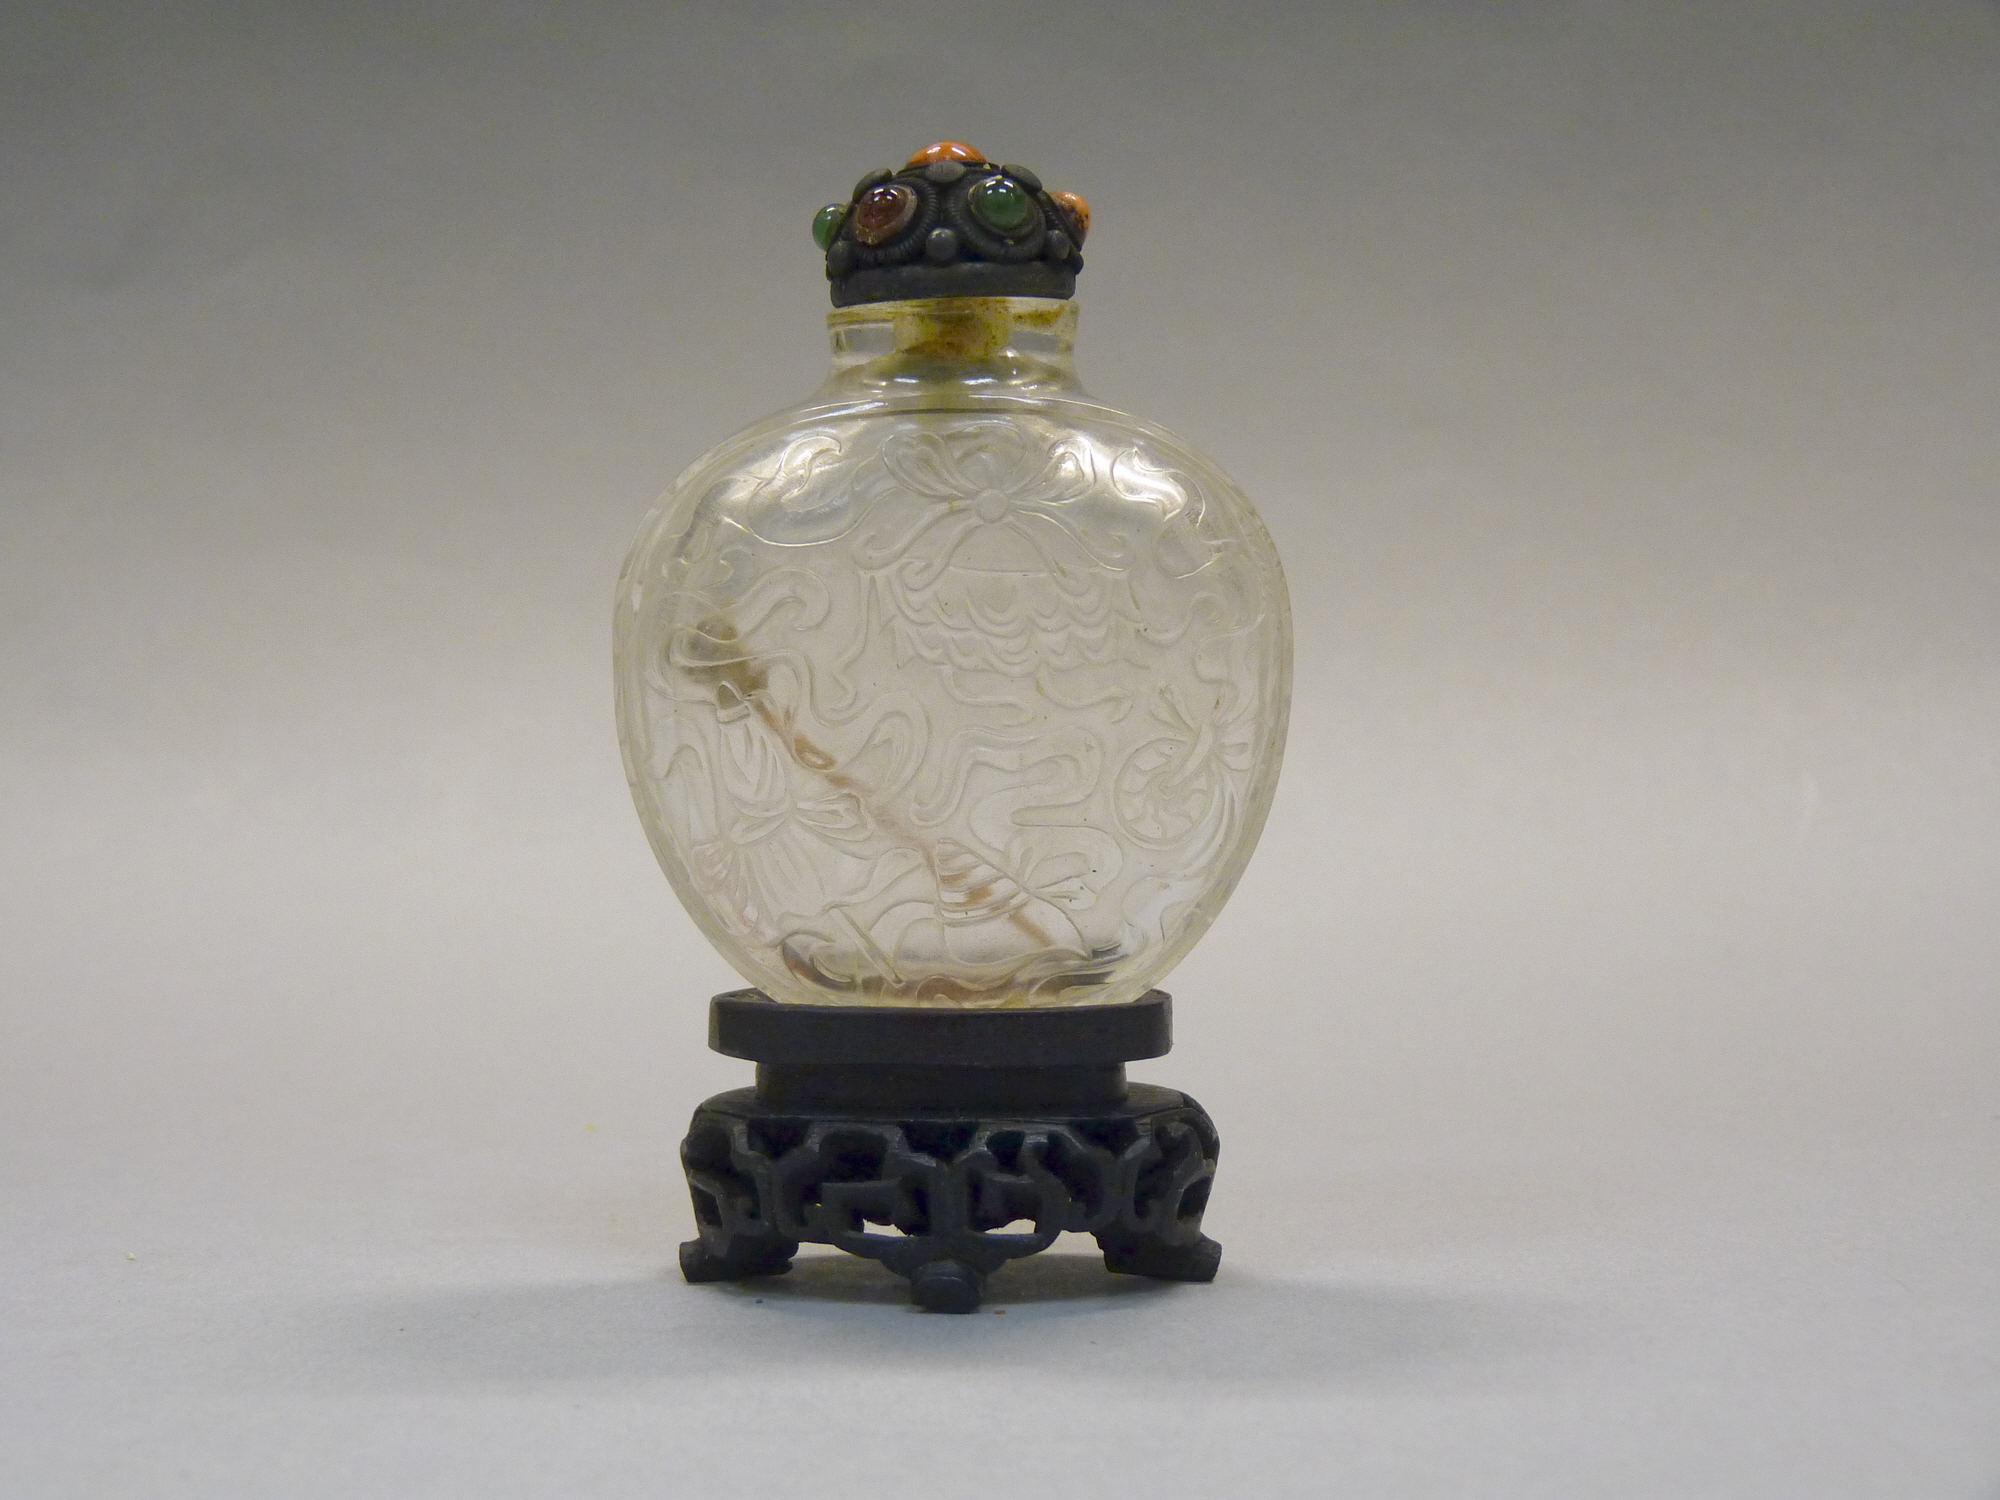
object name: snuff bottle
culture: chinese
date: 1736-1795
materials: crystal, silver, stone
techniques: inlay